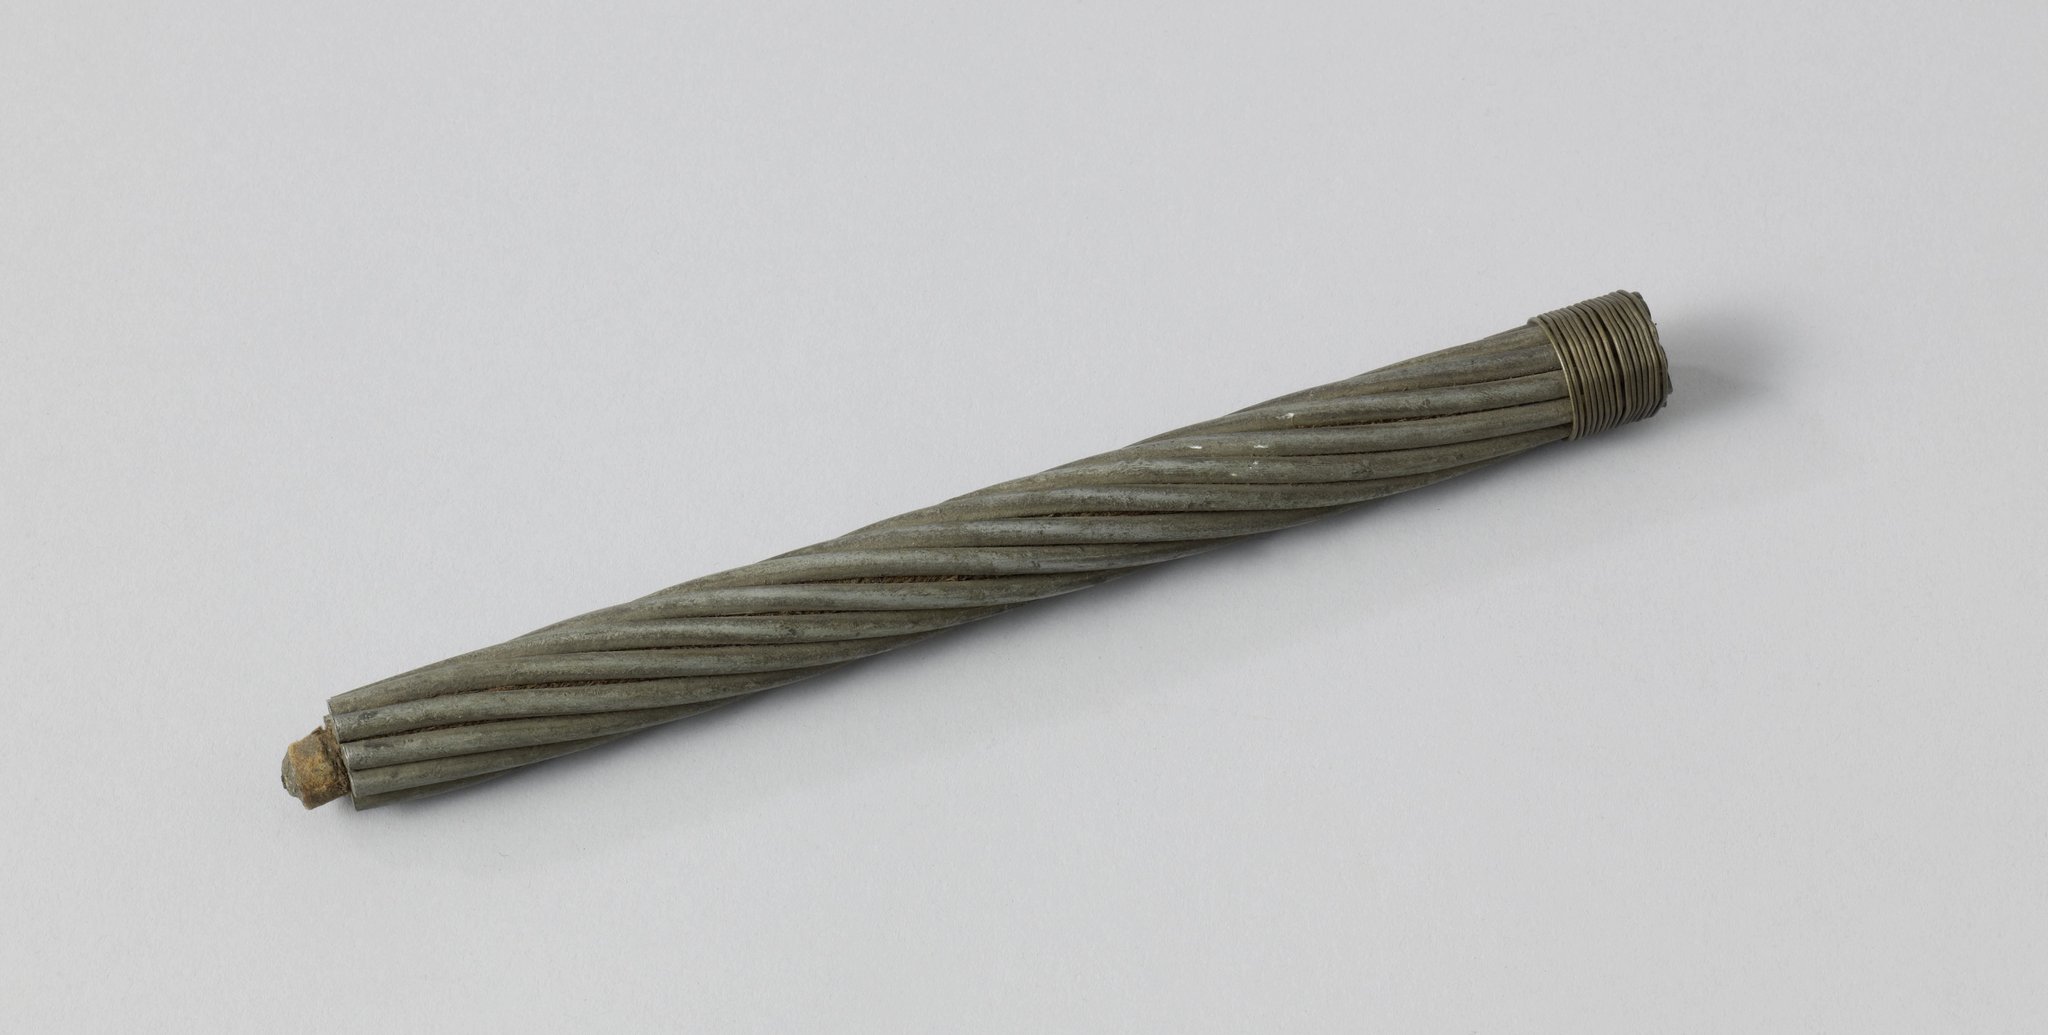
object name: sample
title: Sample of Telegraph Cable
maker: Anonymous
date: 1865-1875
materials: copper, iron, paper, plastic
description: Monster van telegraafkabel, vermoedelijk voor zeemijnen. Het is een kort stuk wantslag staalkabel van tien draden, om een koperdraad in een dikke isolerende laag bestaande uit een onbekende kunststof (vermoedelijk gutta percha) en papier.